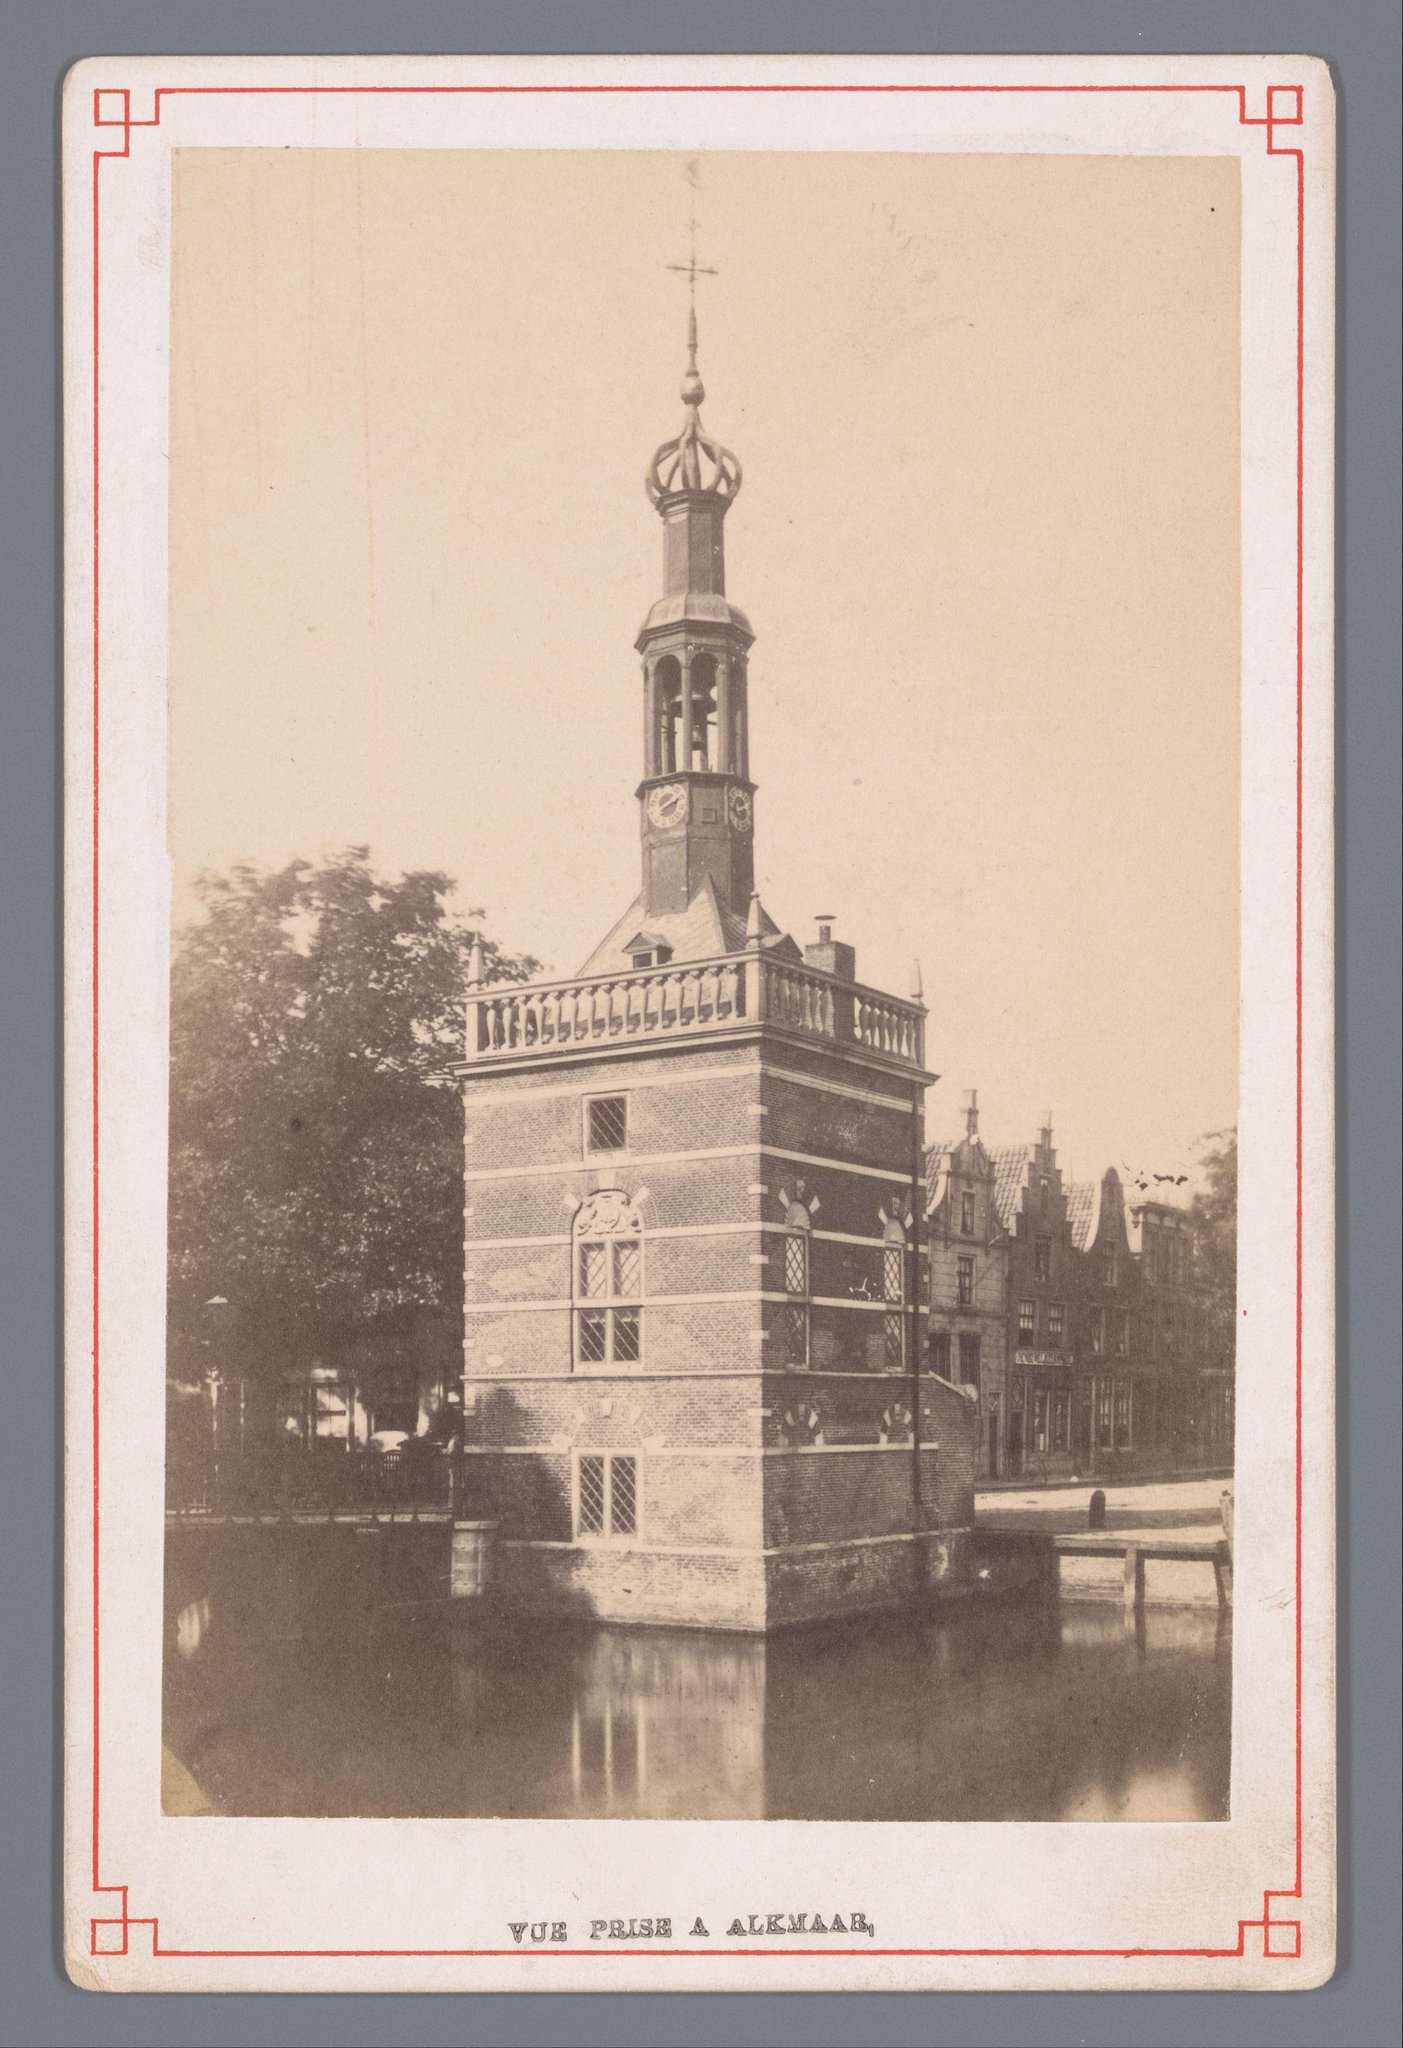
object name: cabinet photograph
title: Accijnshuis te Alkmaar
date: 1880-1900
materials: cardboard, photographic support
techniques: albumen print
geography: alkmaar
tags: civic architecture; edifices; dwellings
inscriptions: inscription: ‘Vue Prise a Alkmaar’, annotation: ‘V/25/ [Swaten]/ Accijnshuis/ Alkmaar/ L.L. (toegeschreven)/ vgl. 1954’